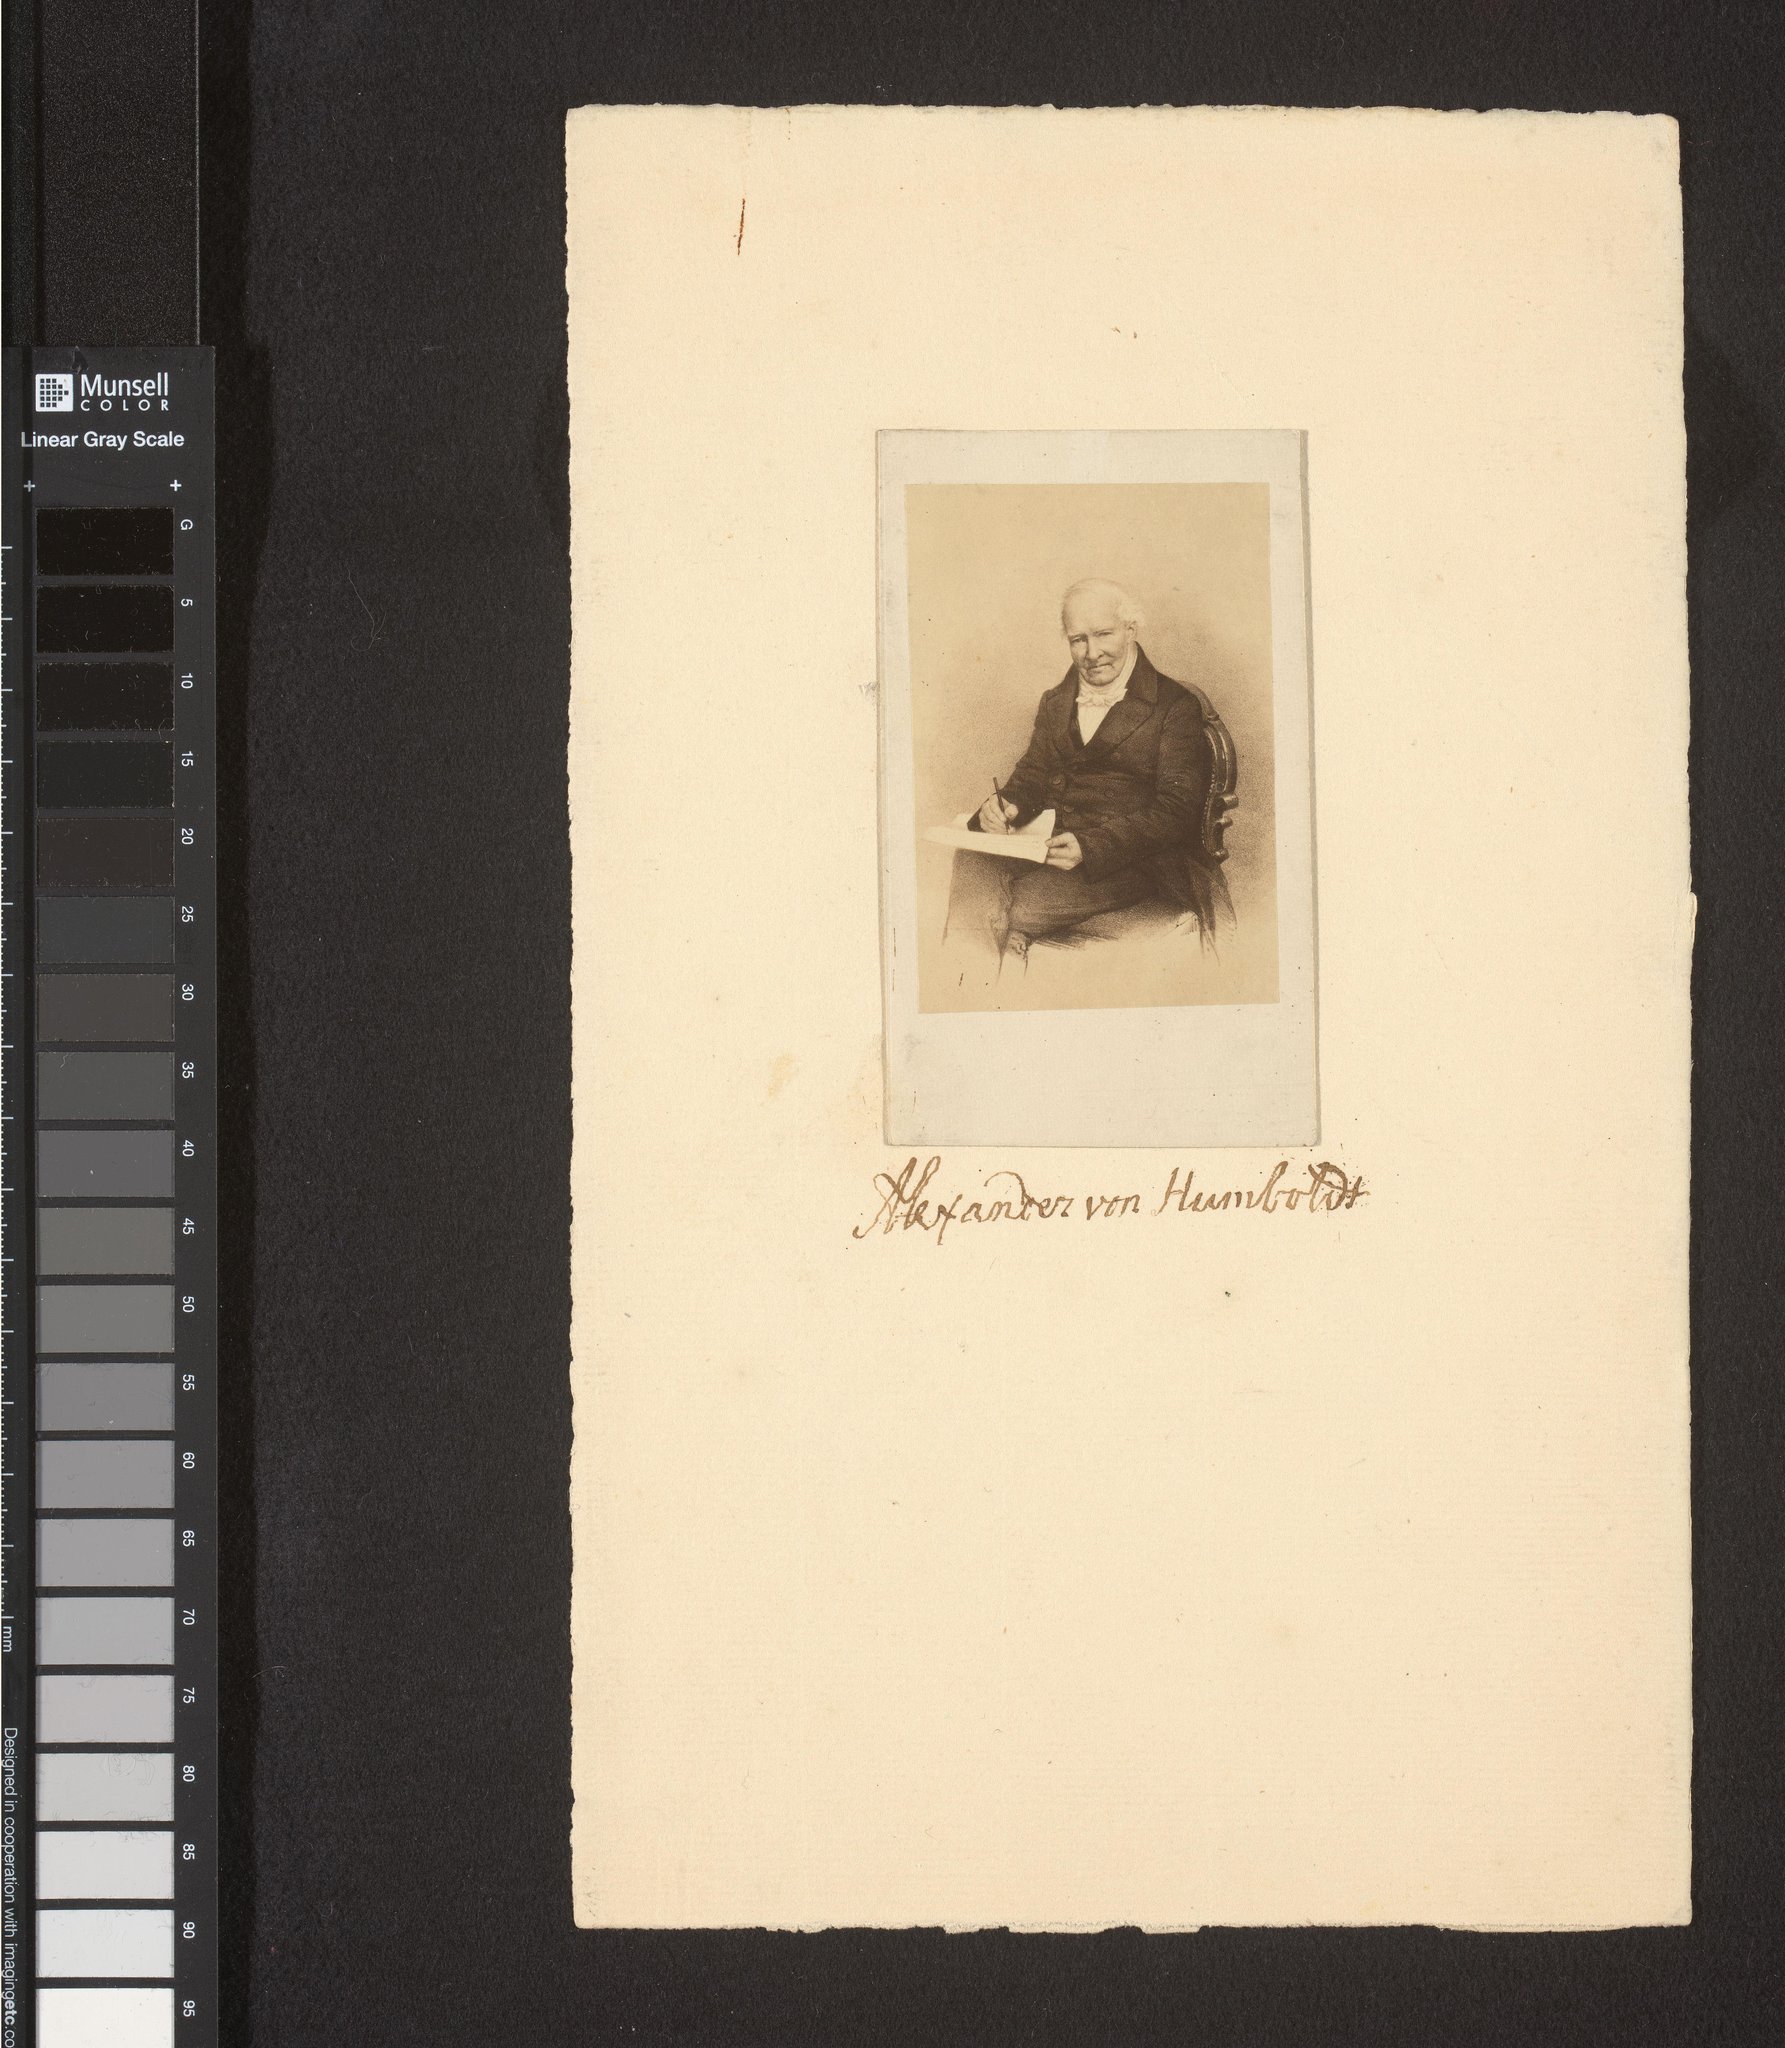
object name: reproduction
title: Fotoreproductie van een litho met een portret van Alexander von Humboldt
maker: Anonymous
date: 1860-1875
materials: cardboard, paper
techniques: albumen print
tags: berlin, traveler, historical persons, science and technology (+ portrait of scholar, scientist)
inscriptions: inscription: ‘Alexander von Humboldt’